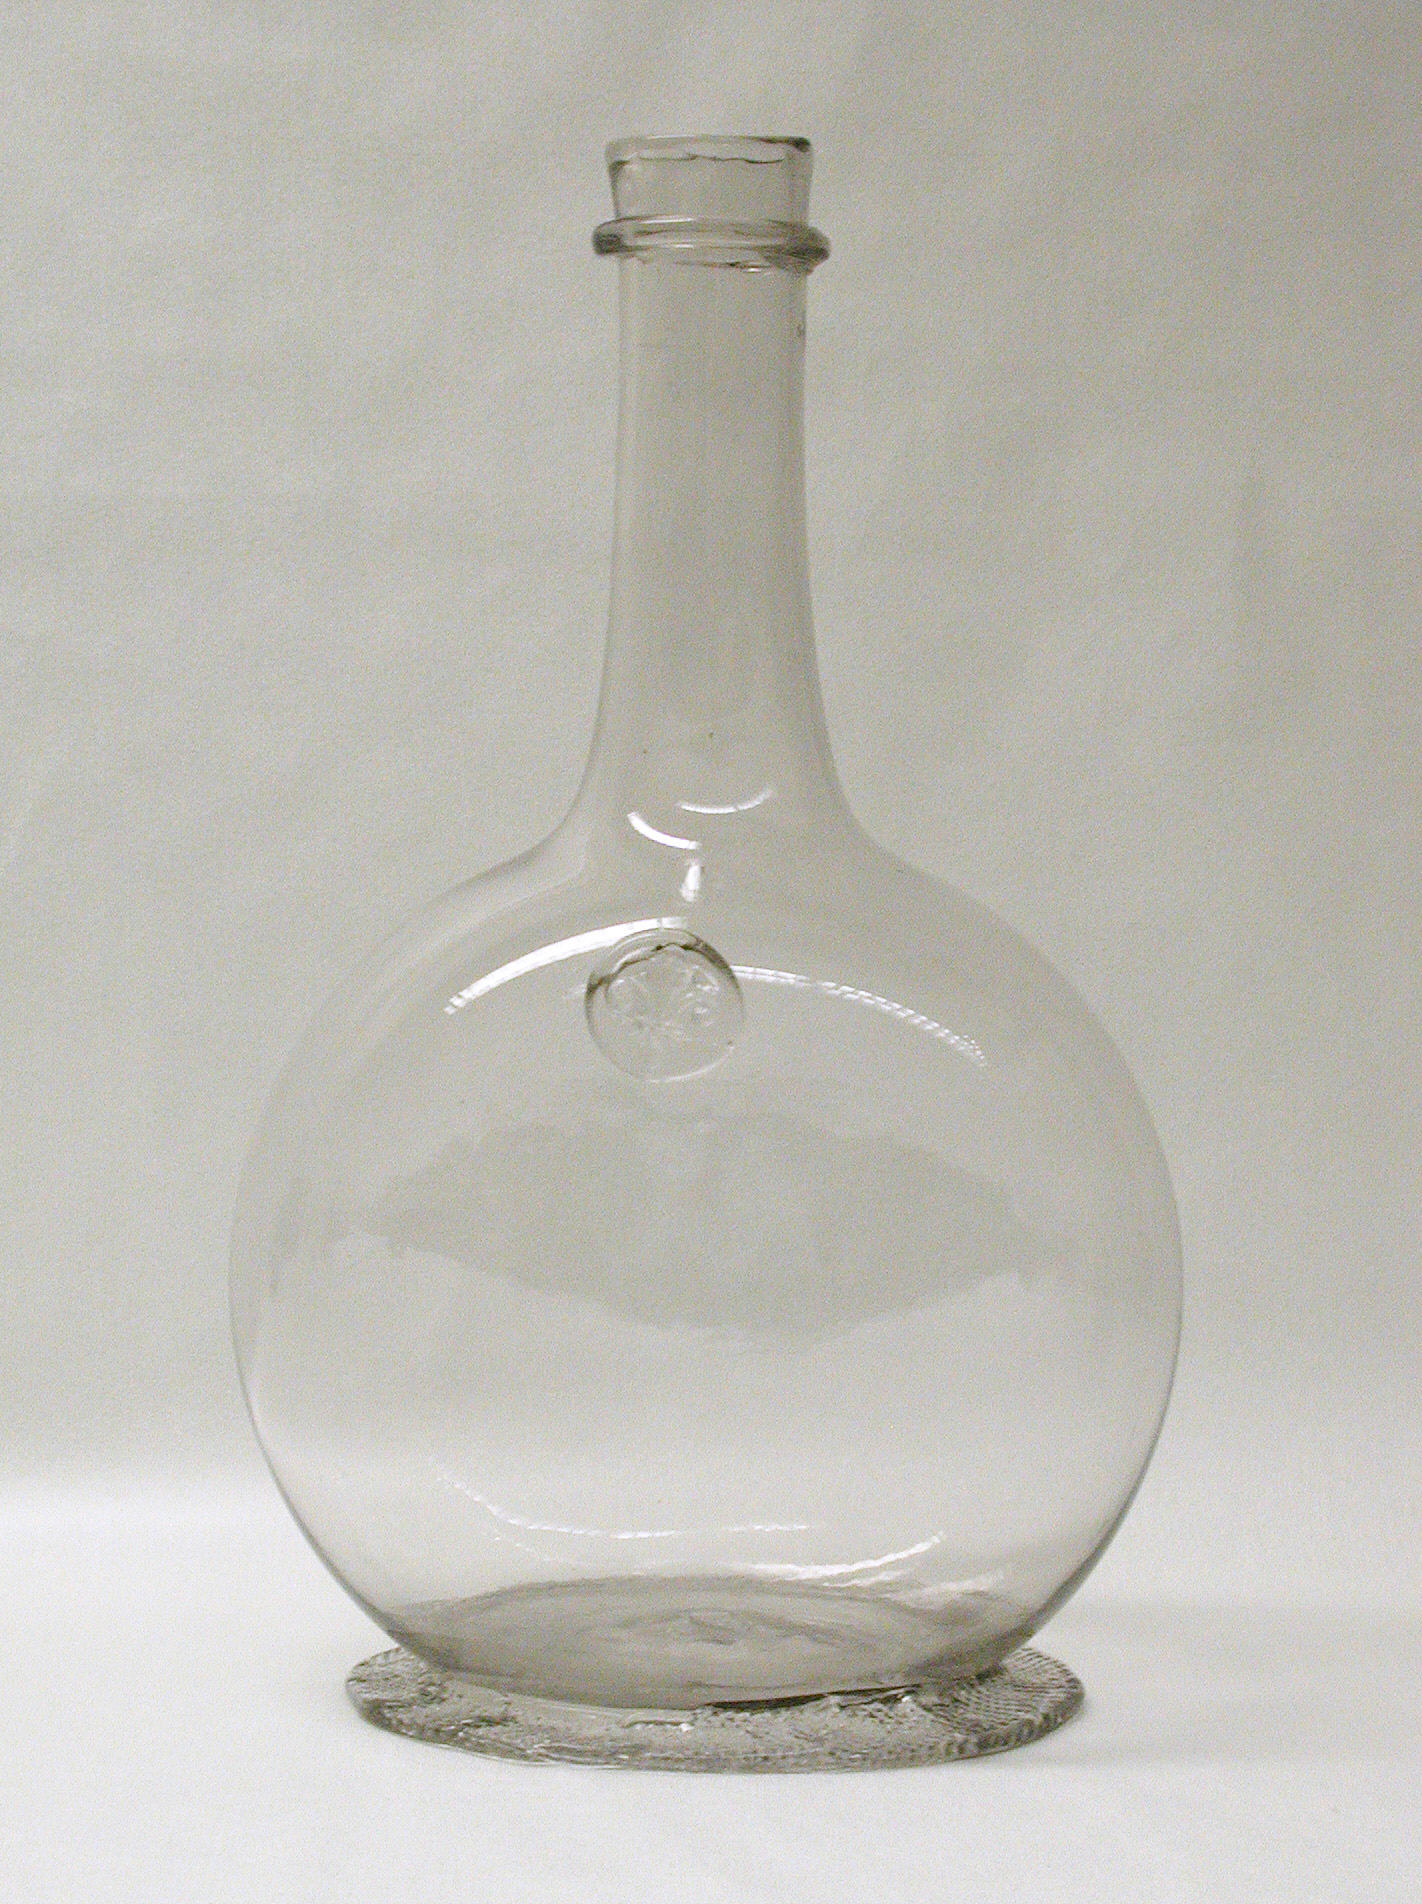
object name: bottle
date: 1701-1800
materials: glass